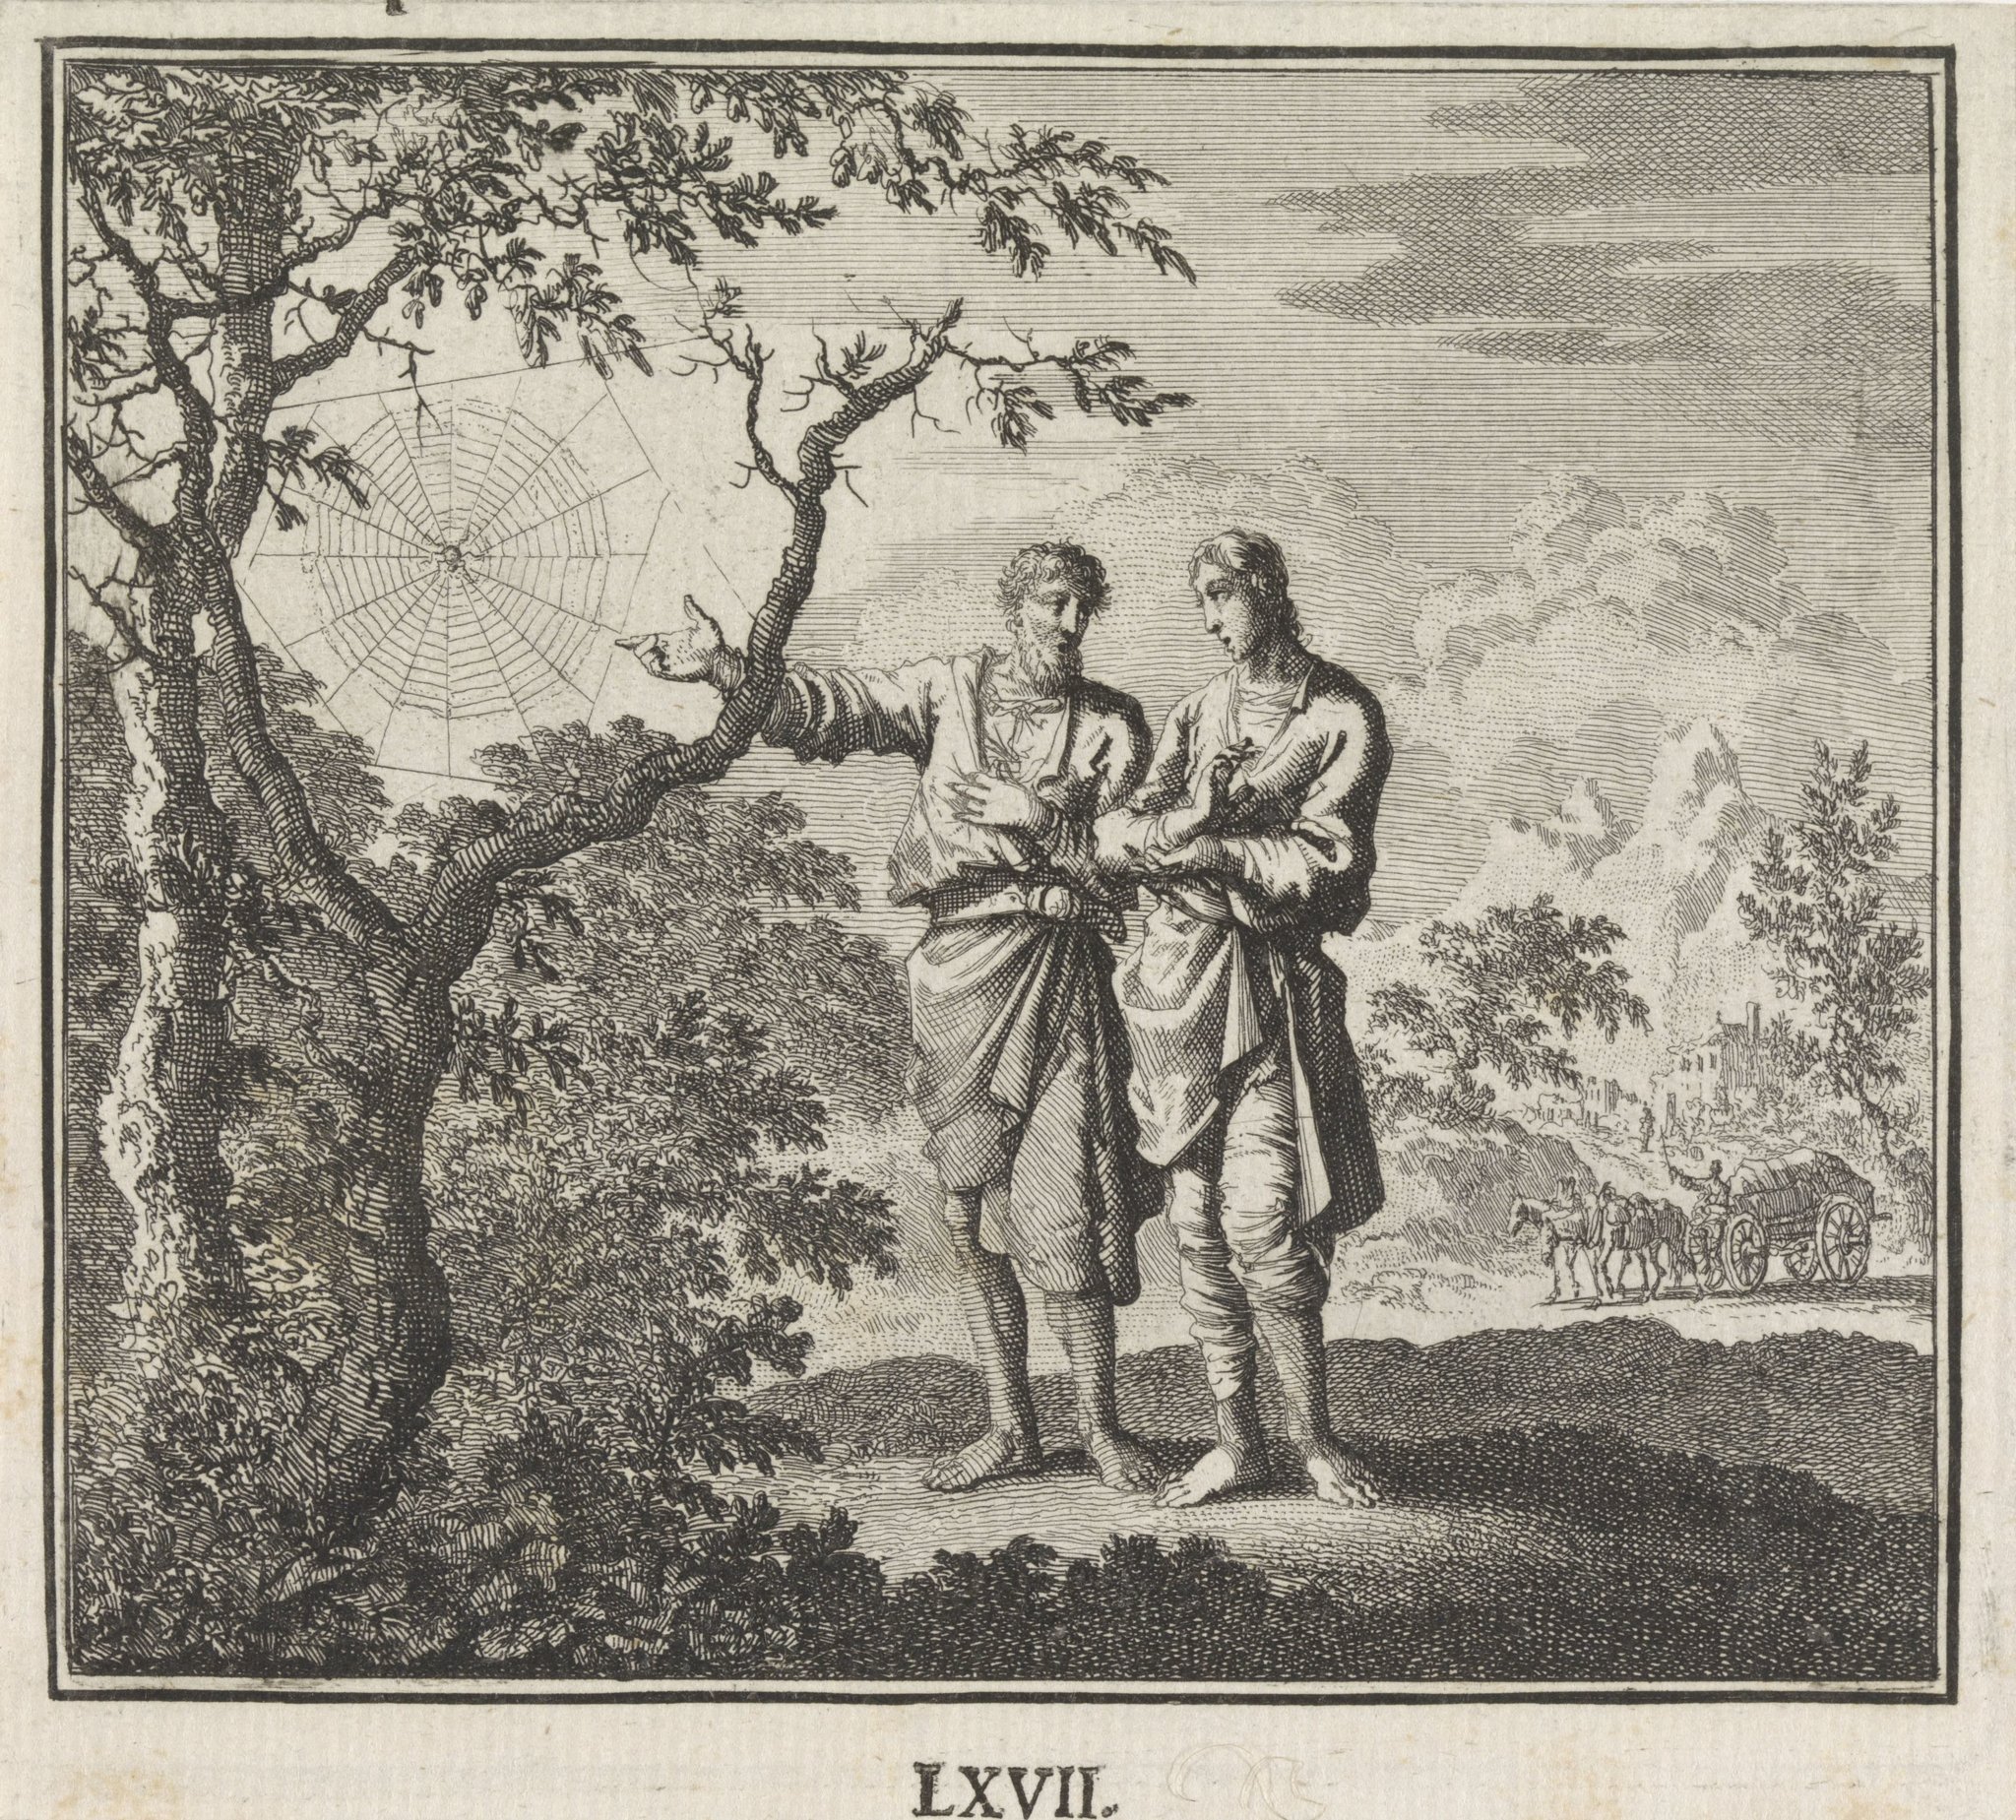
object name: print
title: Twee mannen bekijken een spinnenweb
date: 1695-1705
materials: paper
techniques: etching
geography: nuremberg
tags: adult man (+ two persons), trees, spiders, abstract ideas and concepts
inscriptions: collector's mark: Lugt 2228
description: Boekillustratie voor Weigel, Christoph. Ethica Naturalis seu Documenta Moralia e Variis rerum Naturalium proprietatibus Virtutum Vitiorumq symbolicis imaginibus collecta. Neurenberg: Christoph Weigel: c. 1700.